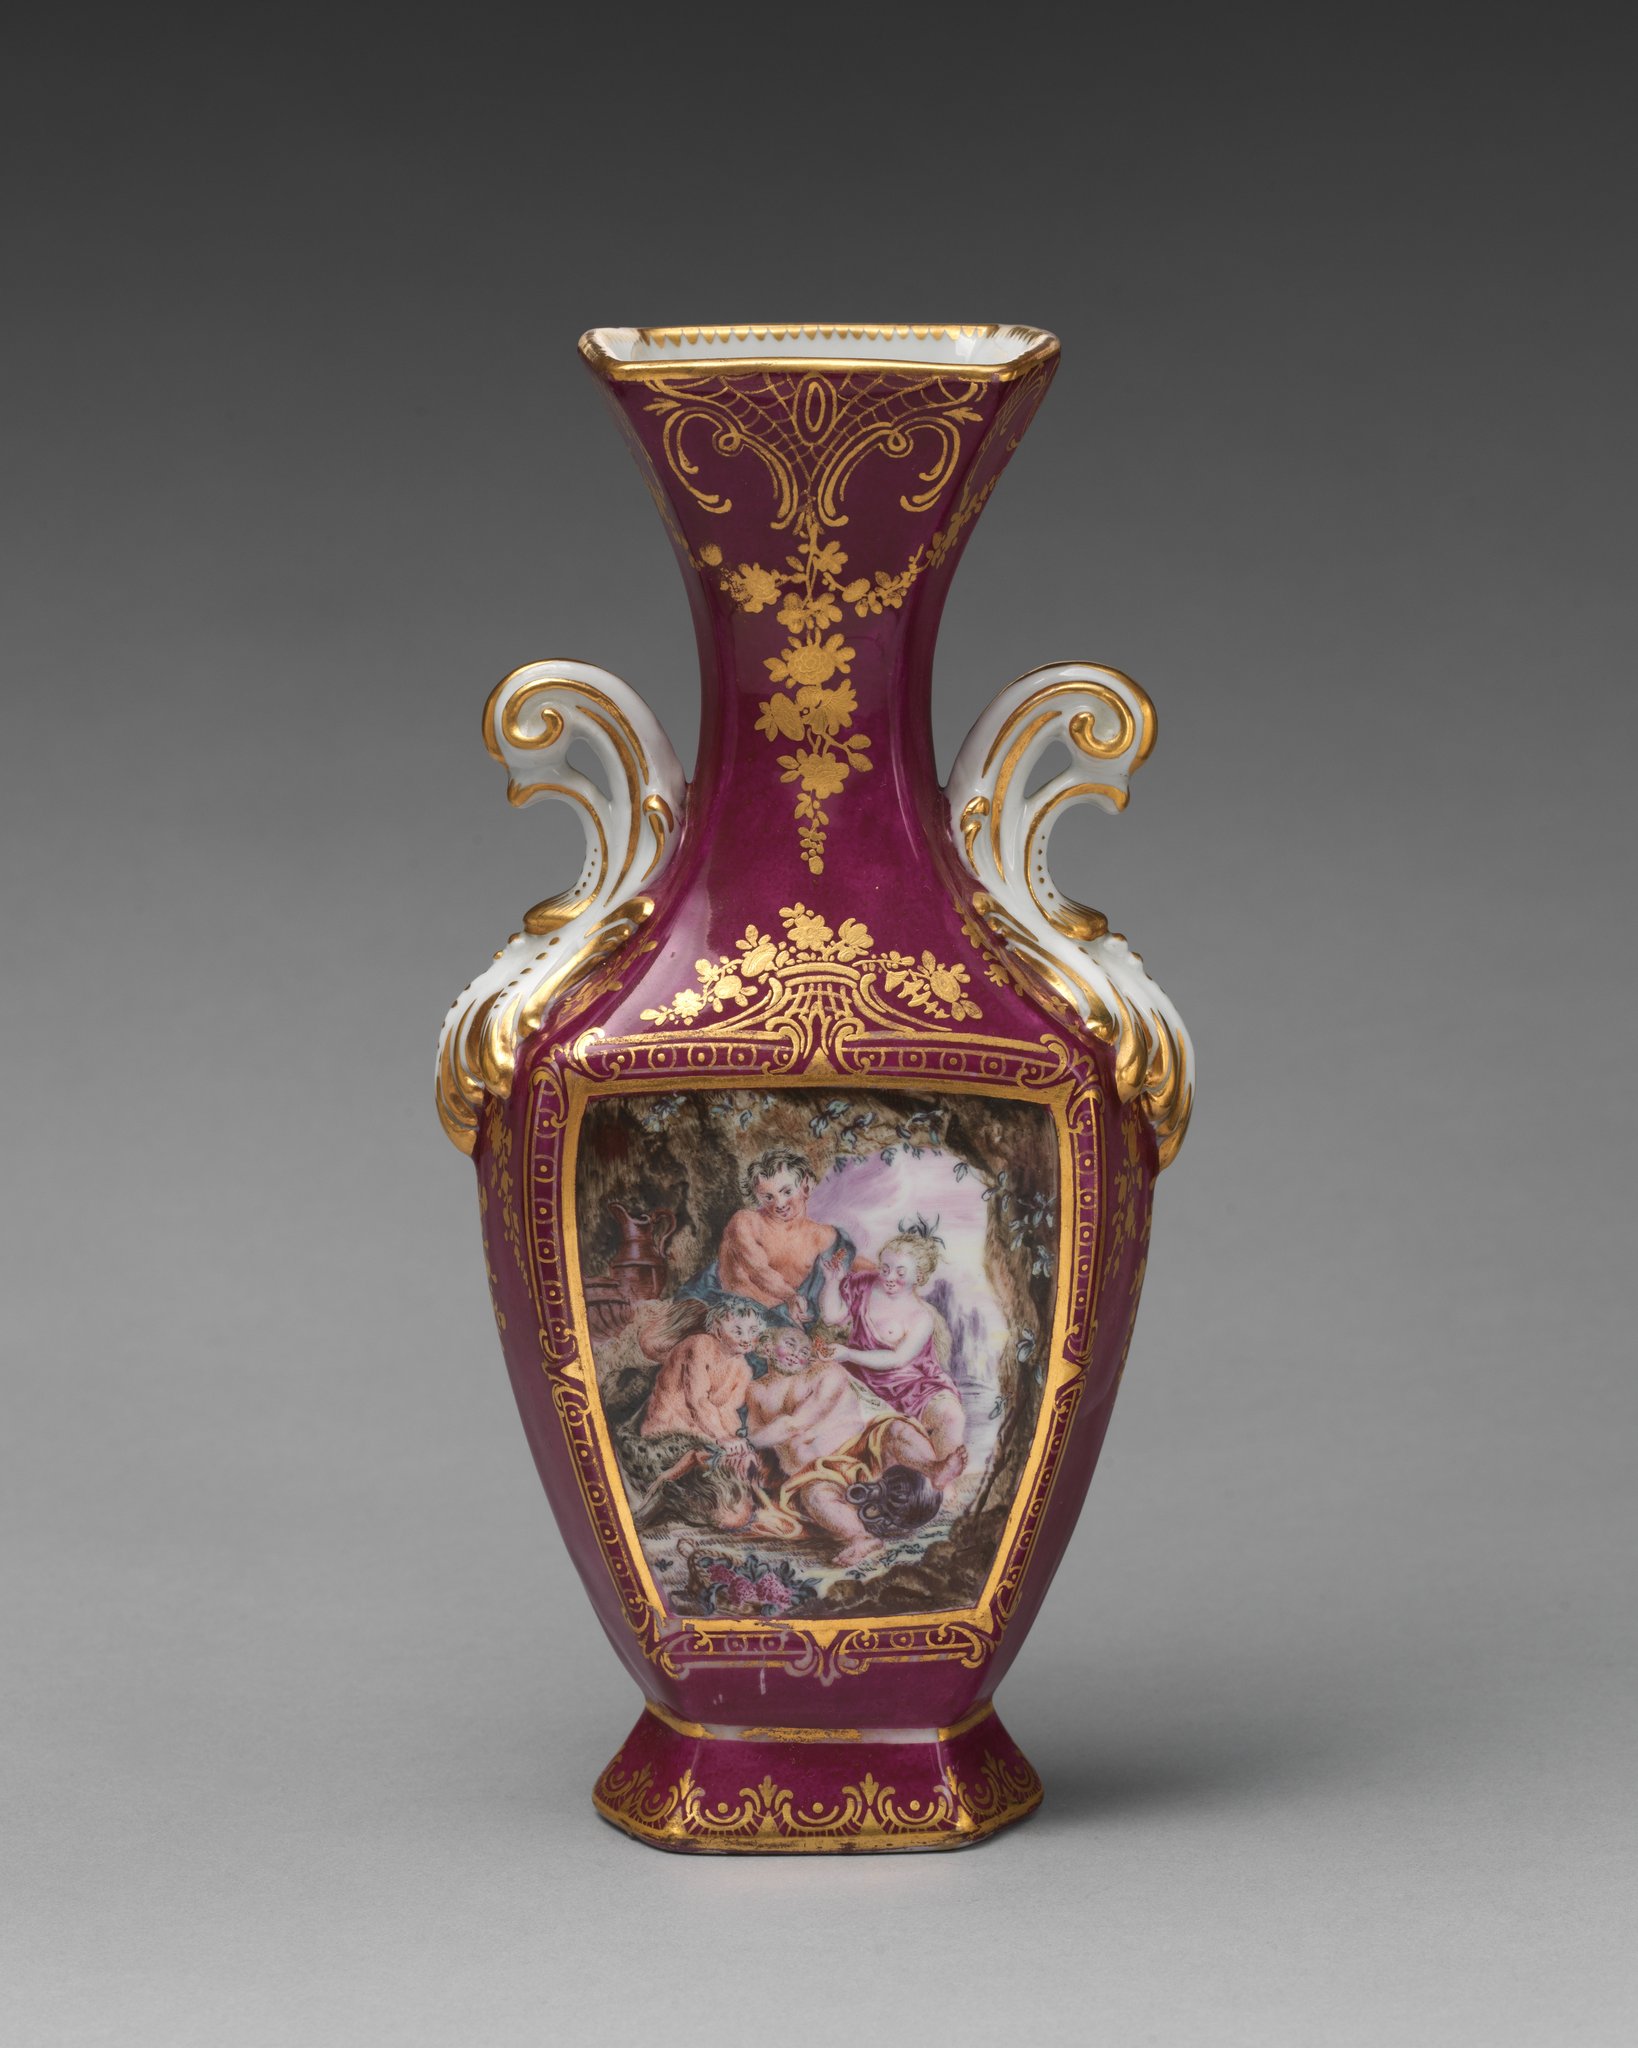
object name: vase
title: Vase (one of a pair)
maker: chelsea porcelain manufactory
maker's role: factory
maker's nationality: british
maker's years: 1744-1784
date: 1761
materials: soft paste porcelain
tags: birds,men,women